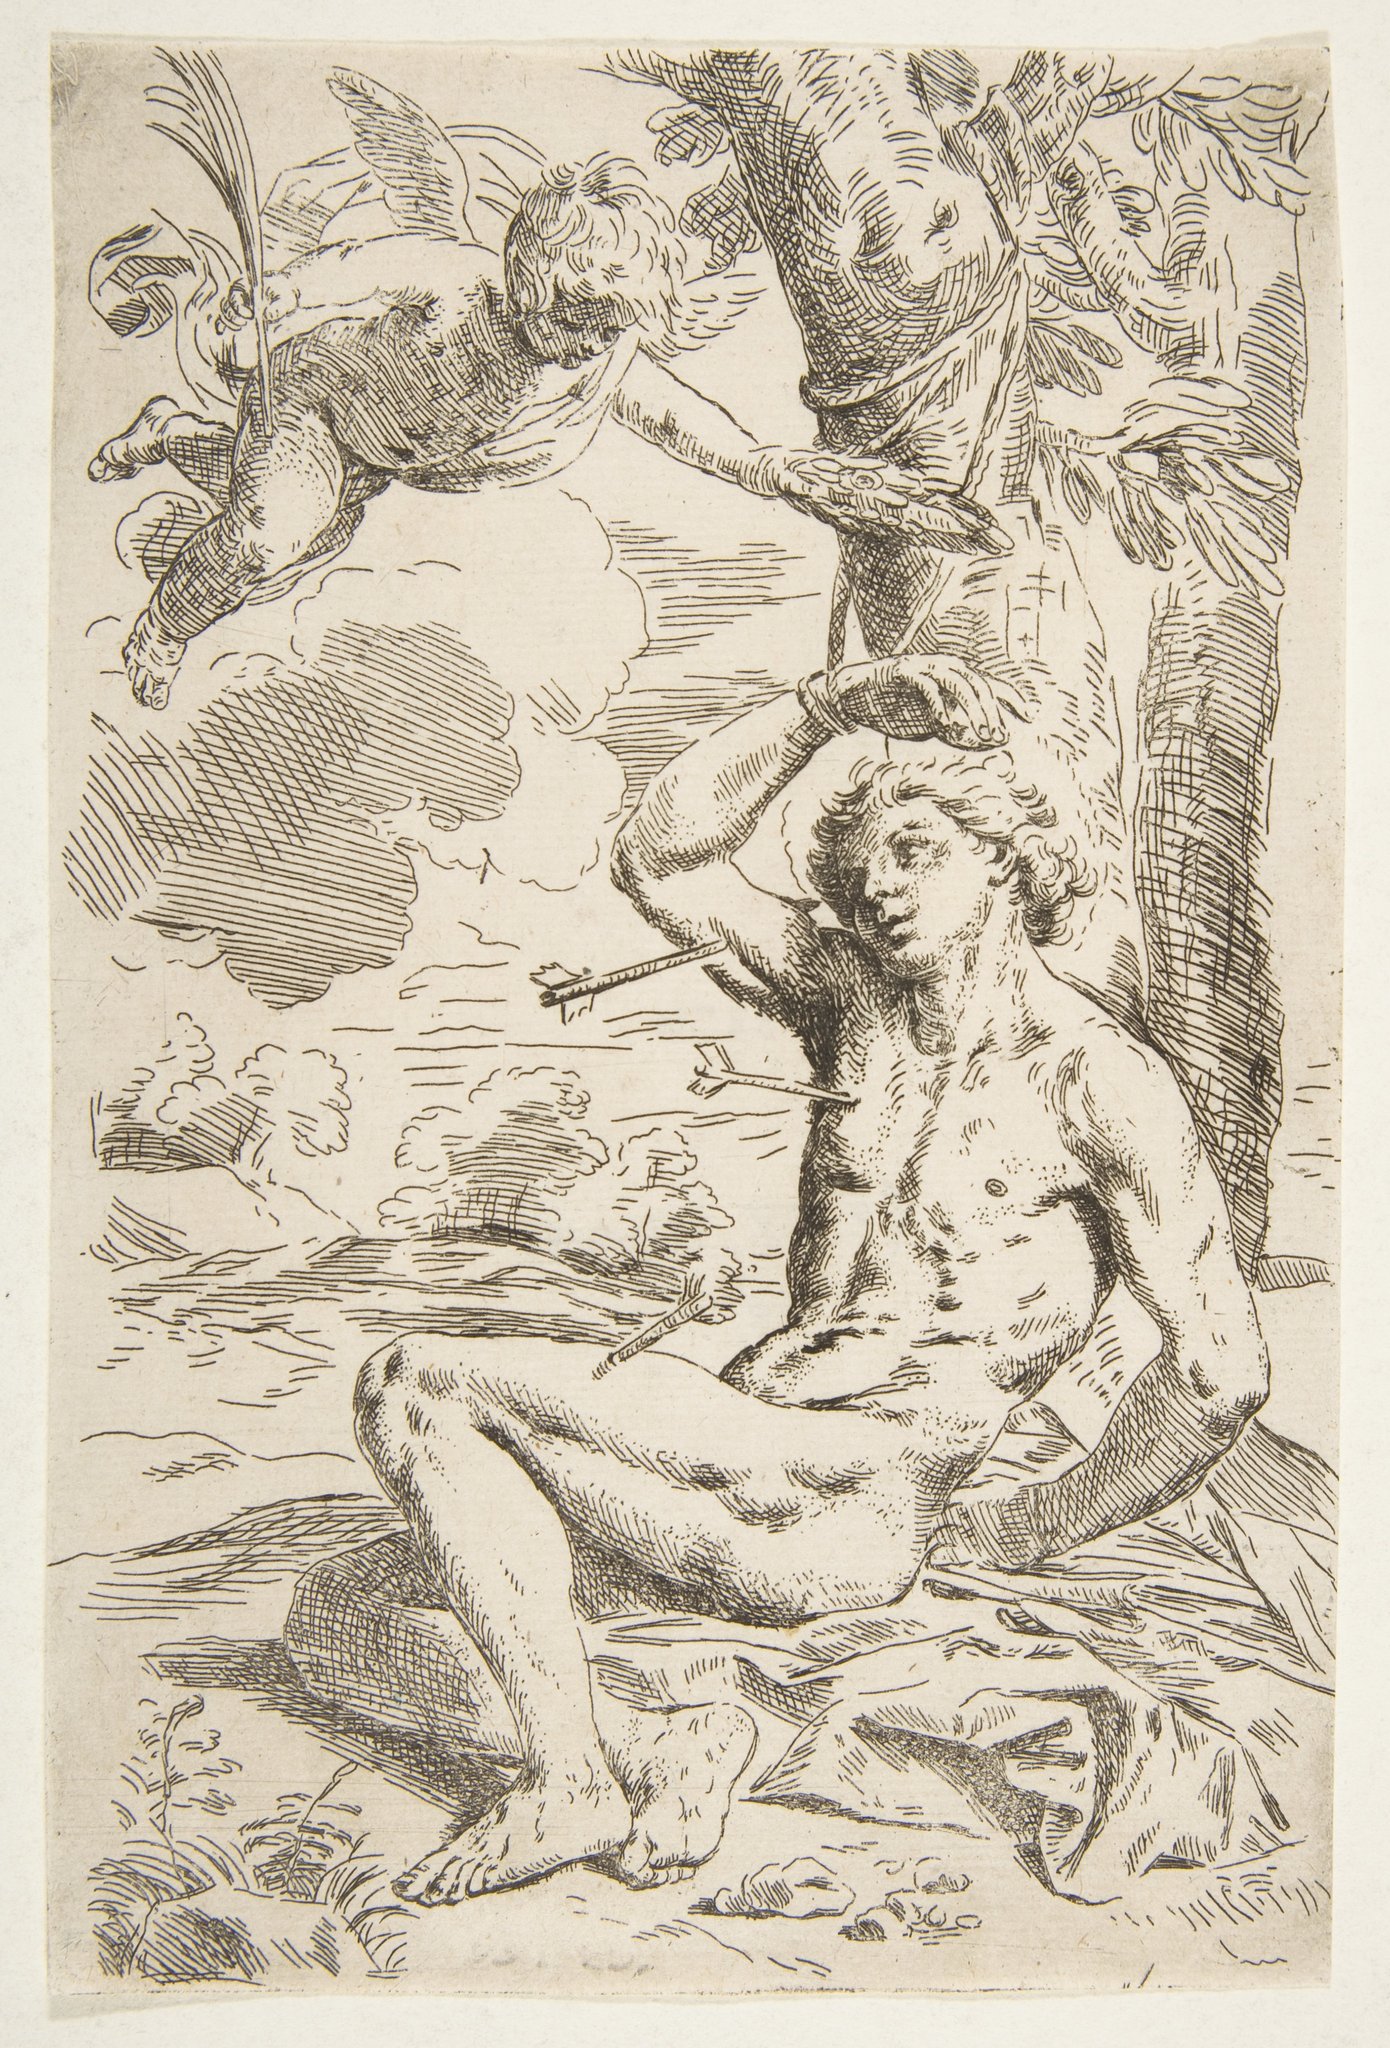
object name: print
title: Saint Sebastian pierced with arrows and tied to a tree, copy after Cantarini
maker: simone cantarini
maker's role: artist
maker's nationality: italian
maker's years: 1612-1648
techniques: etching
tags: arrows,male nudes,cupid,trees,saints